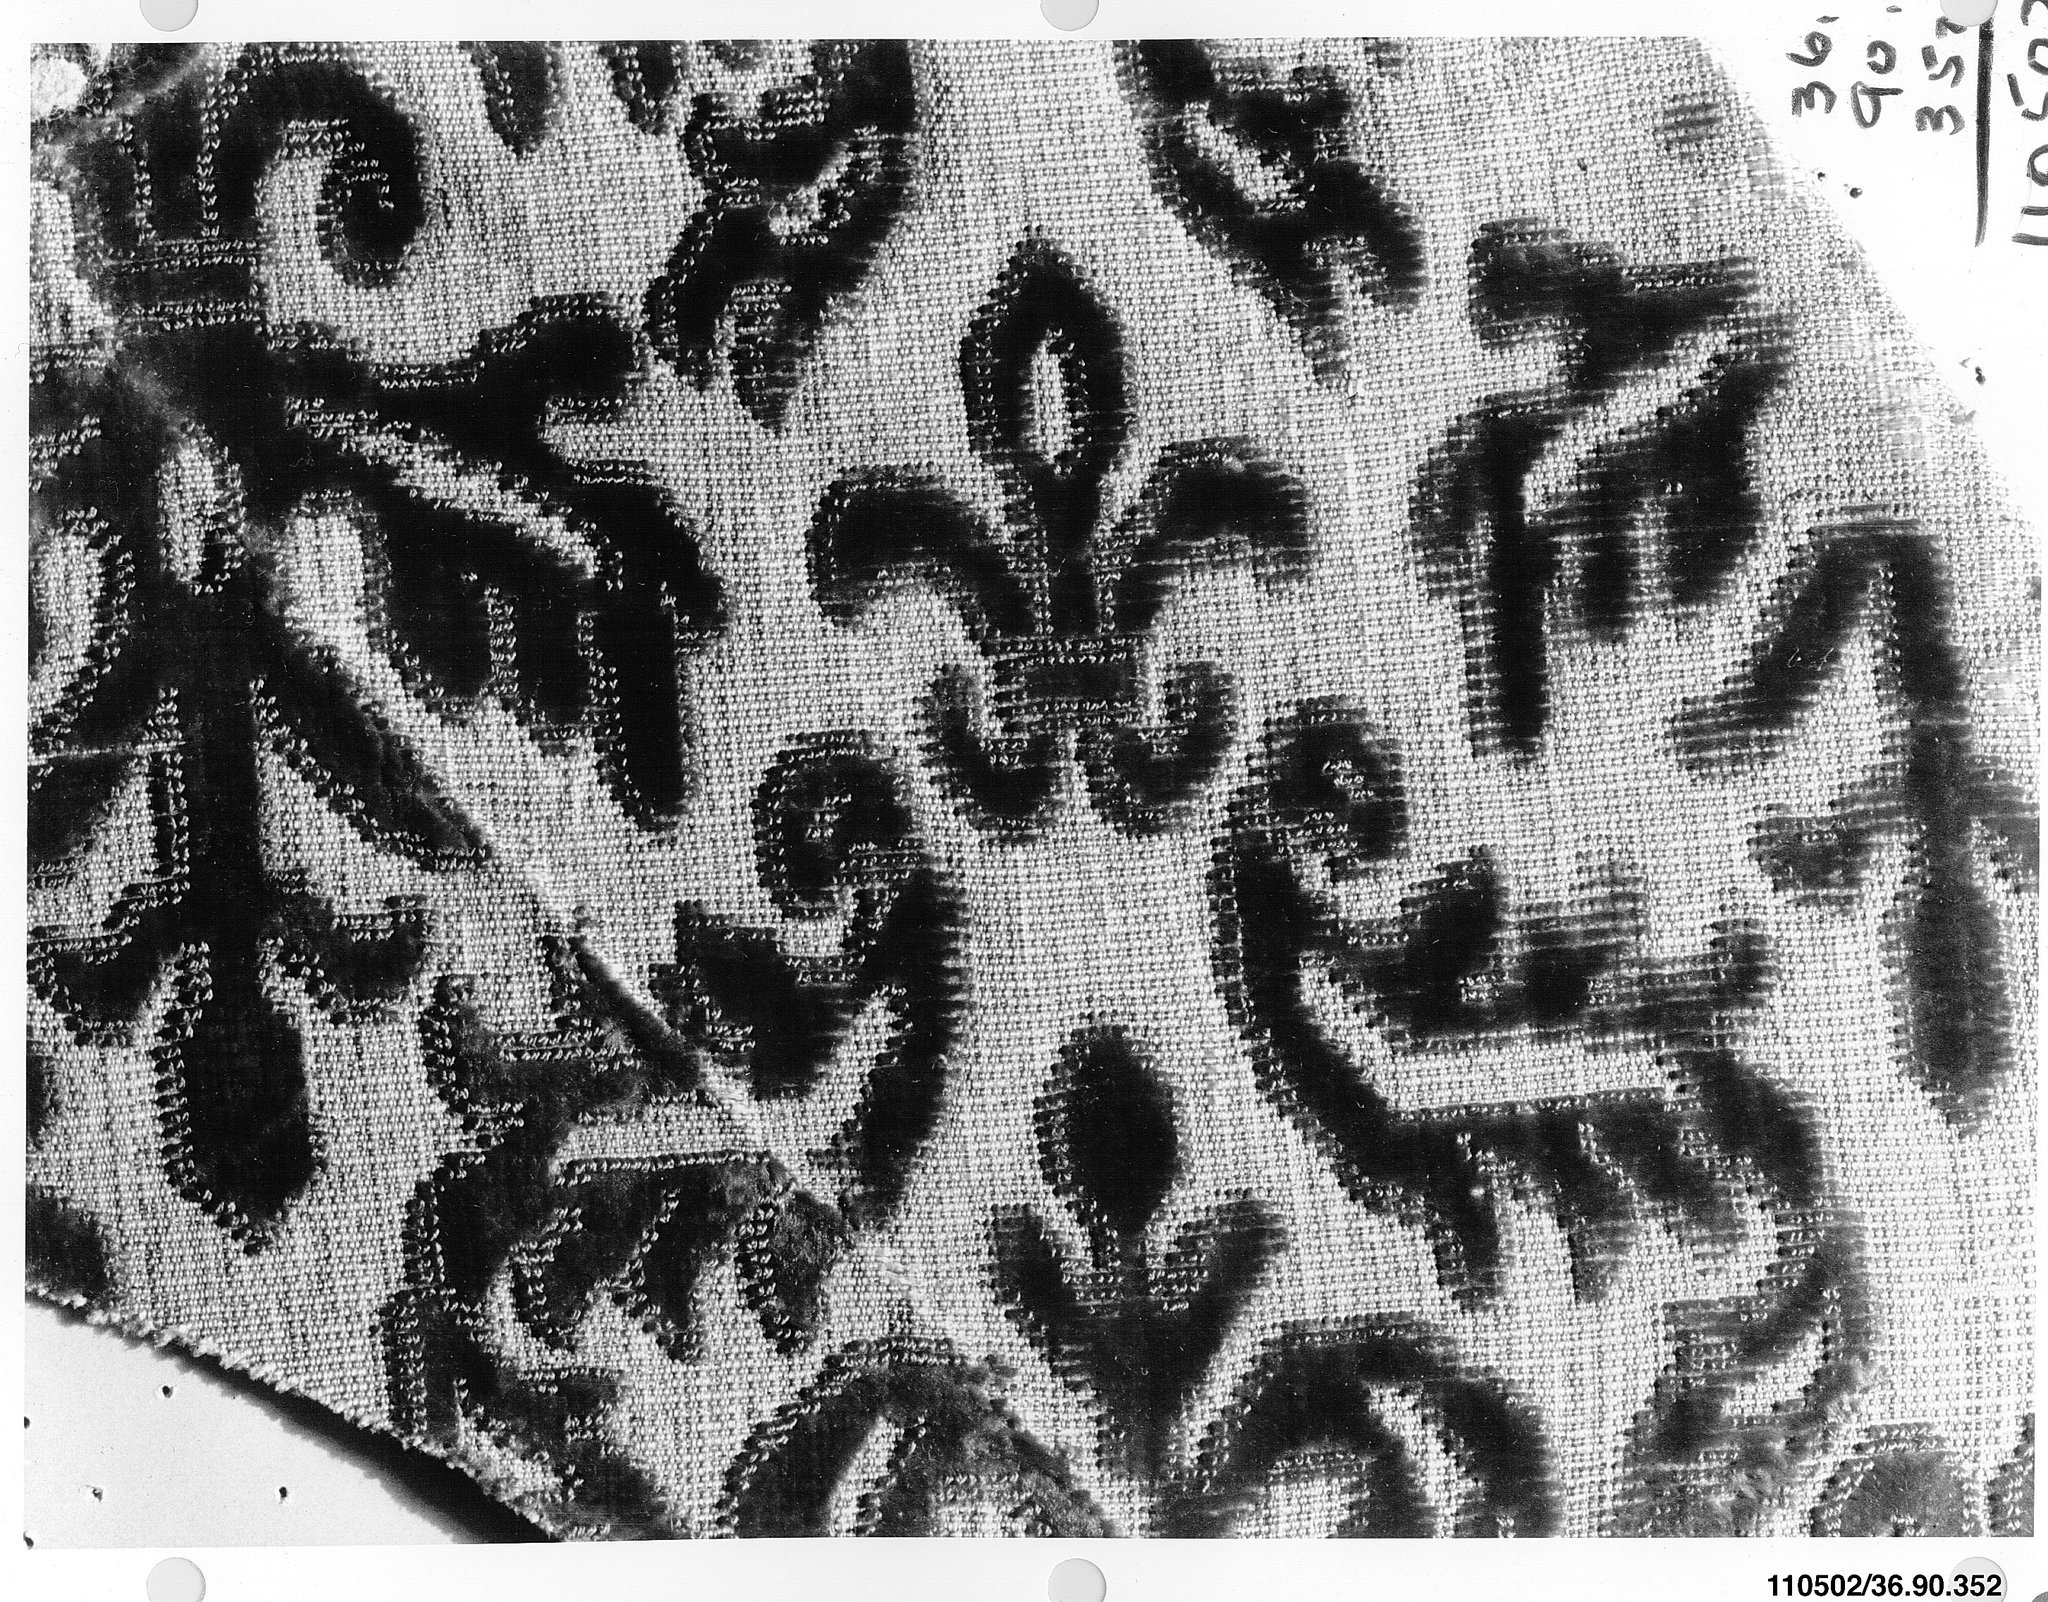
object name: piece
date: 1501-1700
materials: metal thread, silk